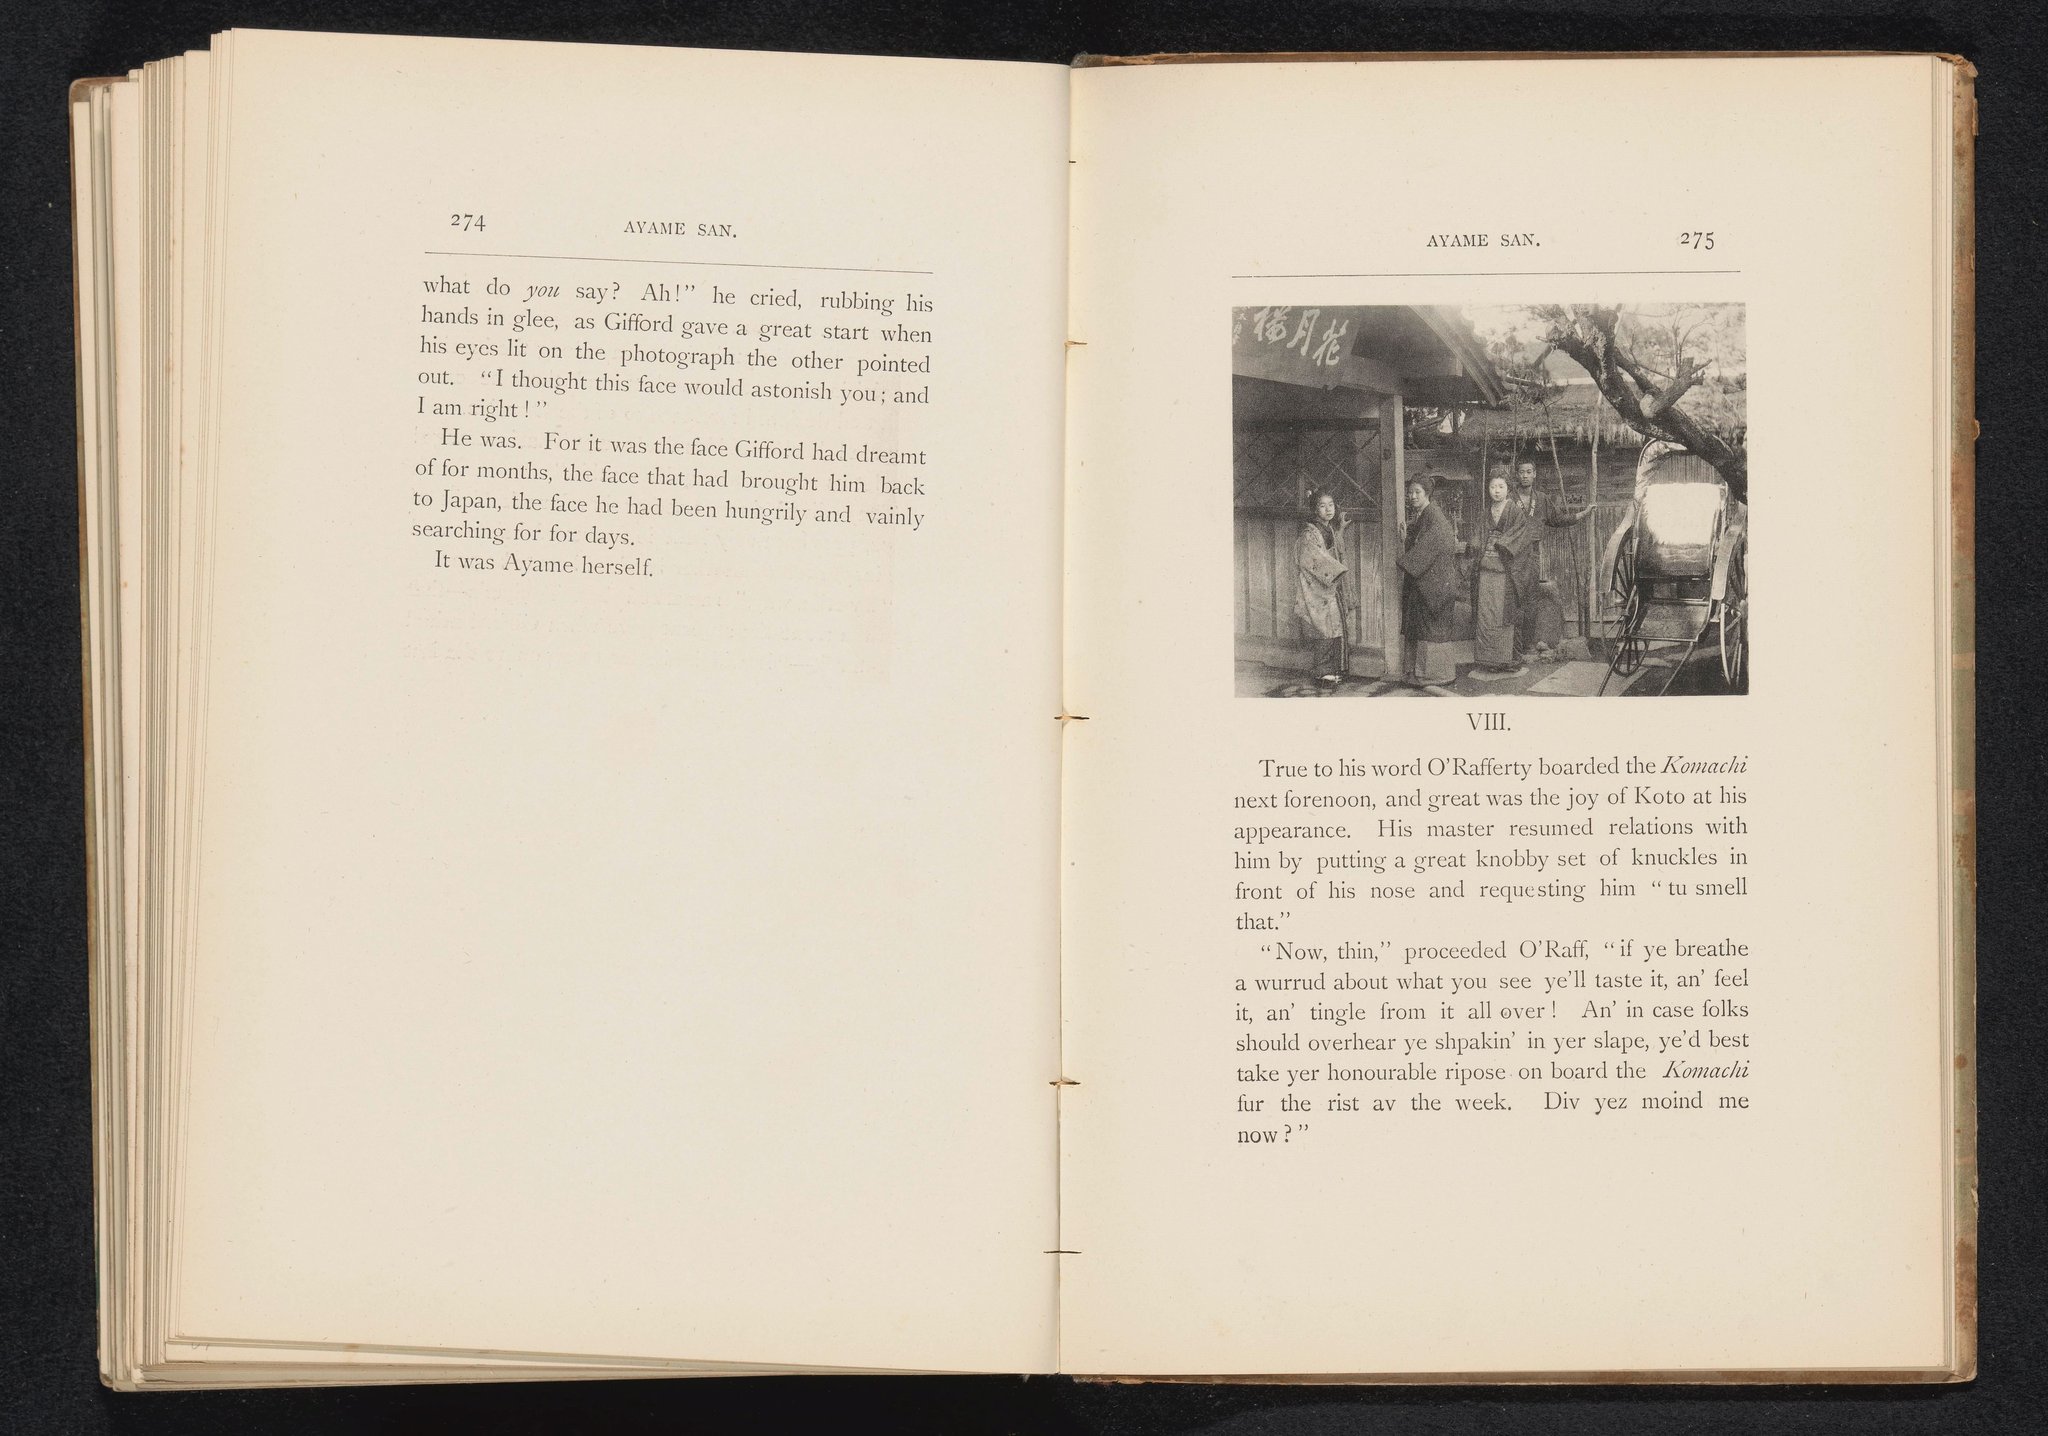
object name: photomechanical print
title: Drie vrouwen en een man naast een riksja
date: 1882-1892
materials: paper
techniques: photograph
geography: japan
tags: rickshaw, adult woman, adult man